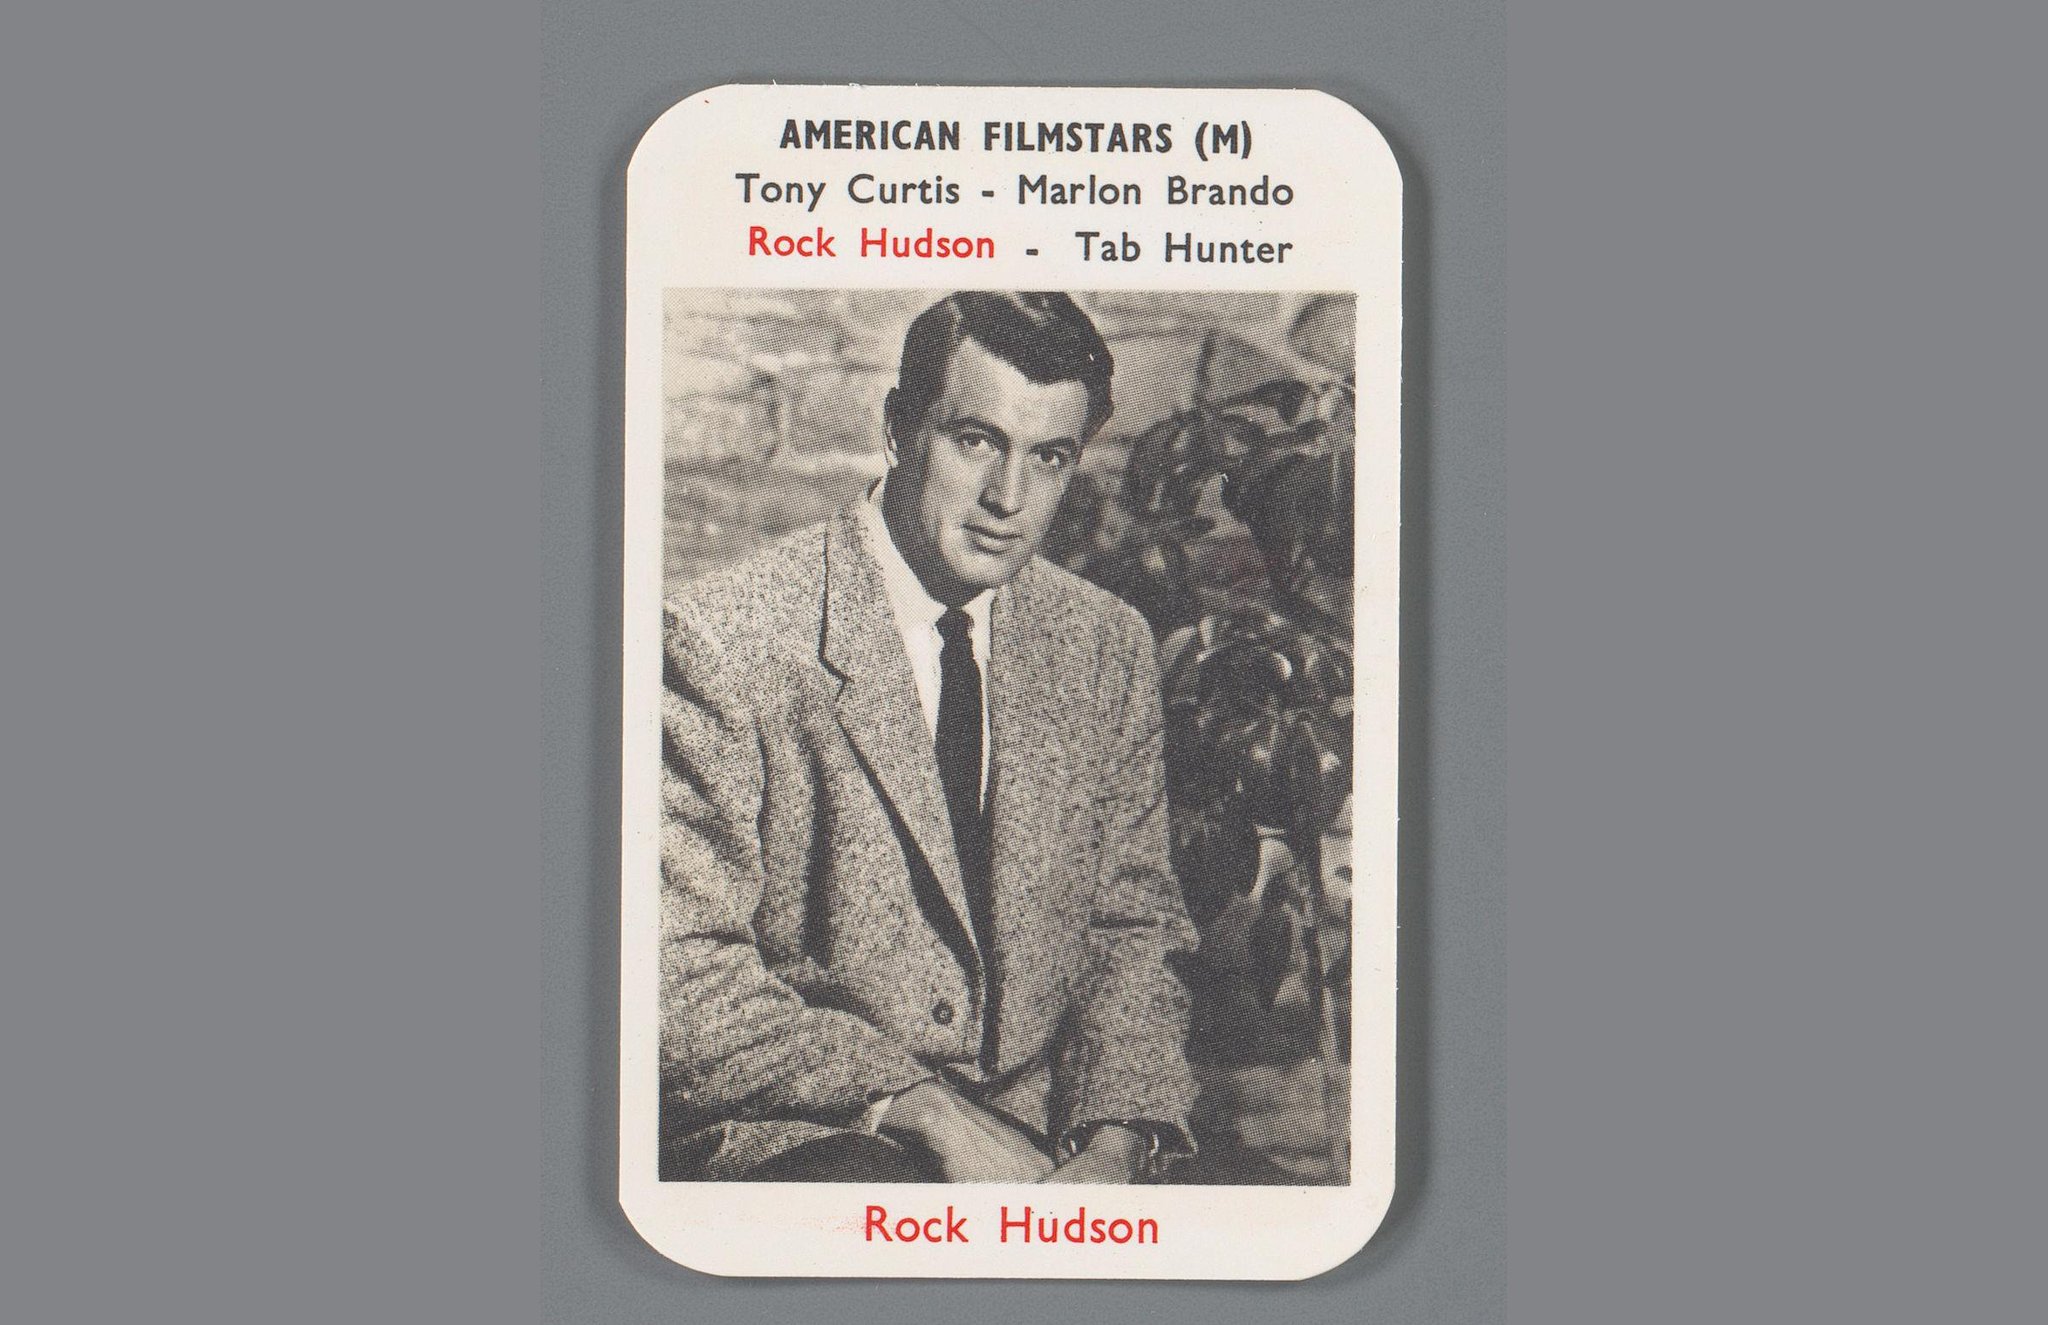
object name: playing card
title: Rock Hudson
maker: Anonymous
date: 1960-1970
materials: paper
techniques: autotype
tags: portrait of actor, actress